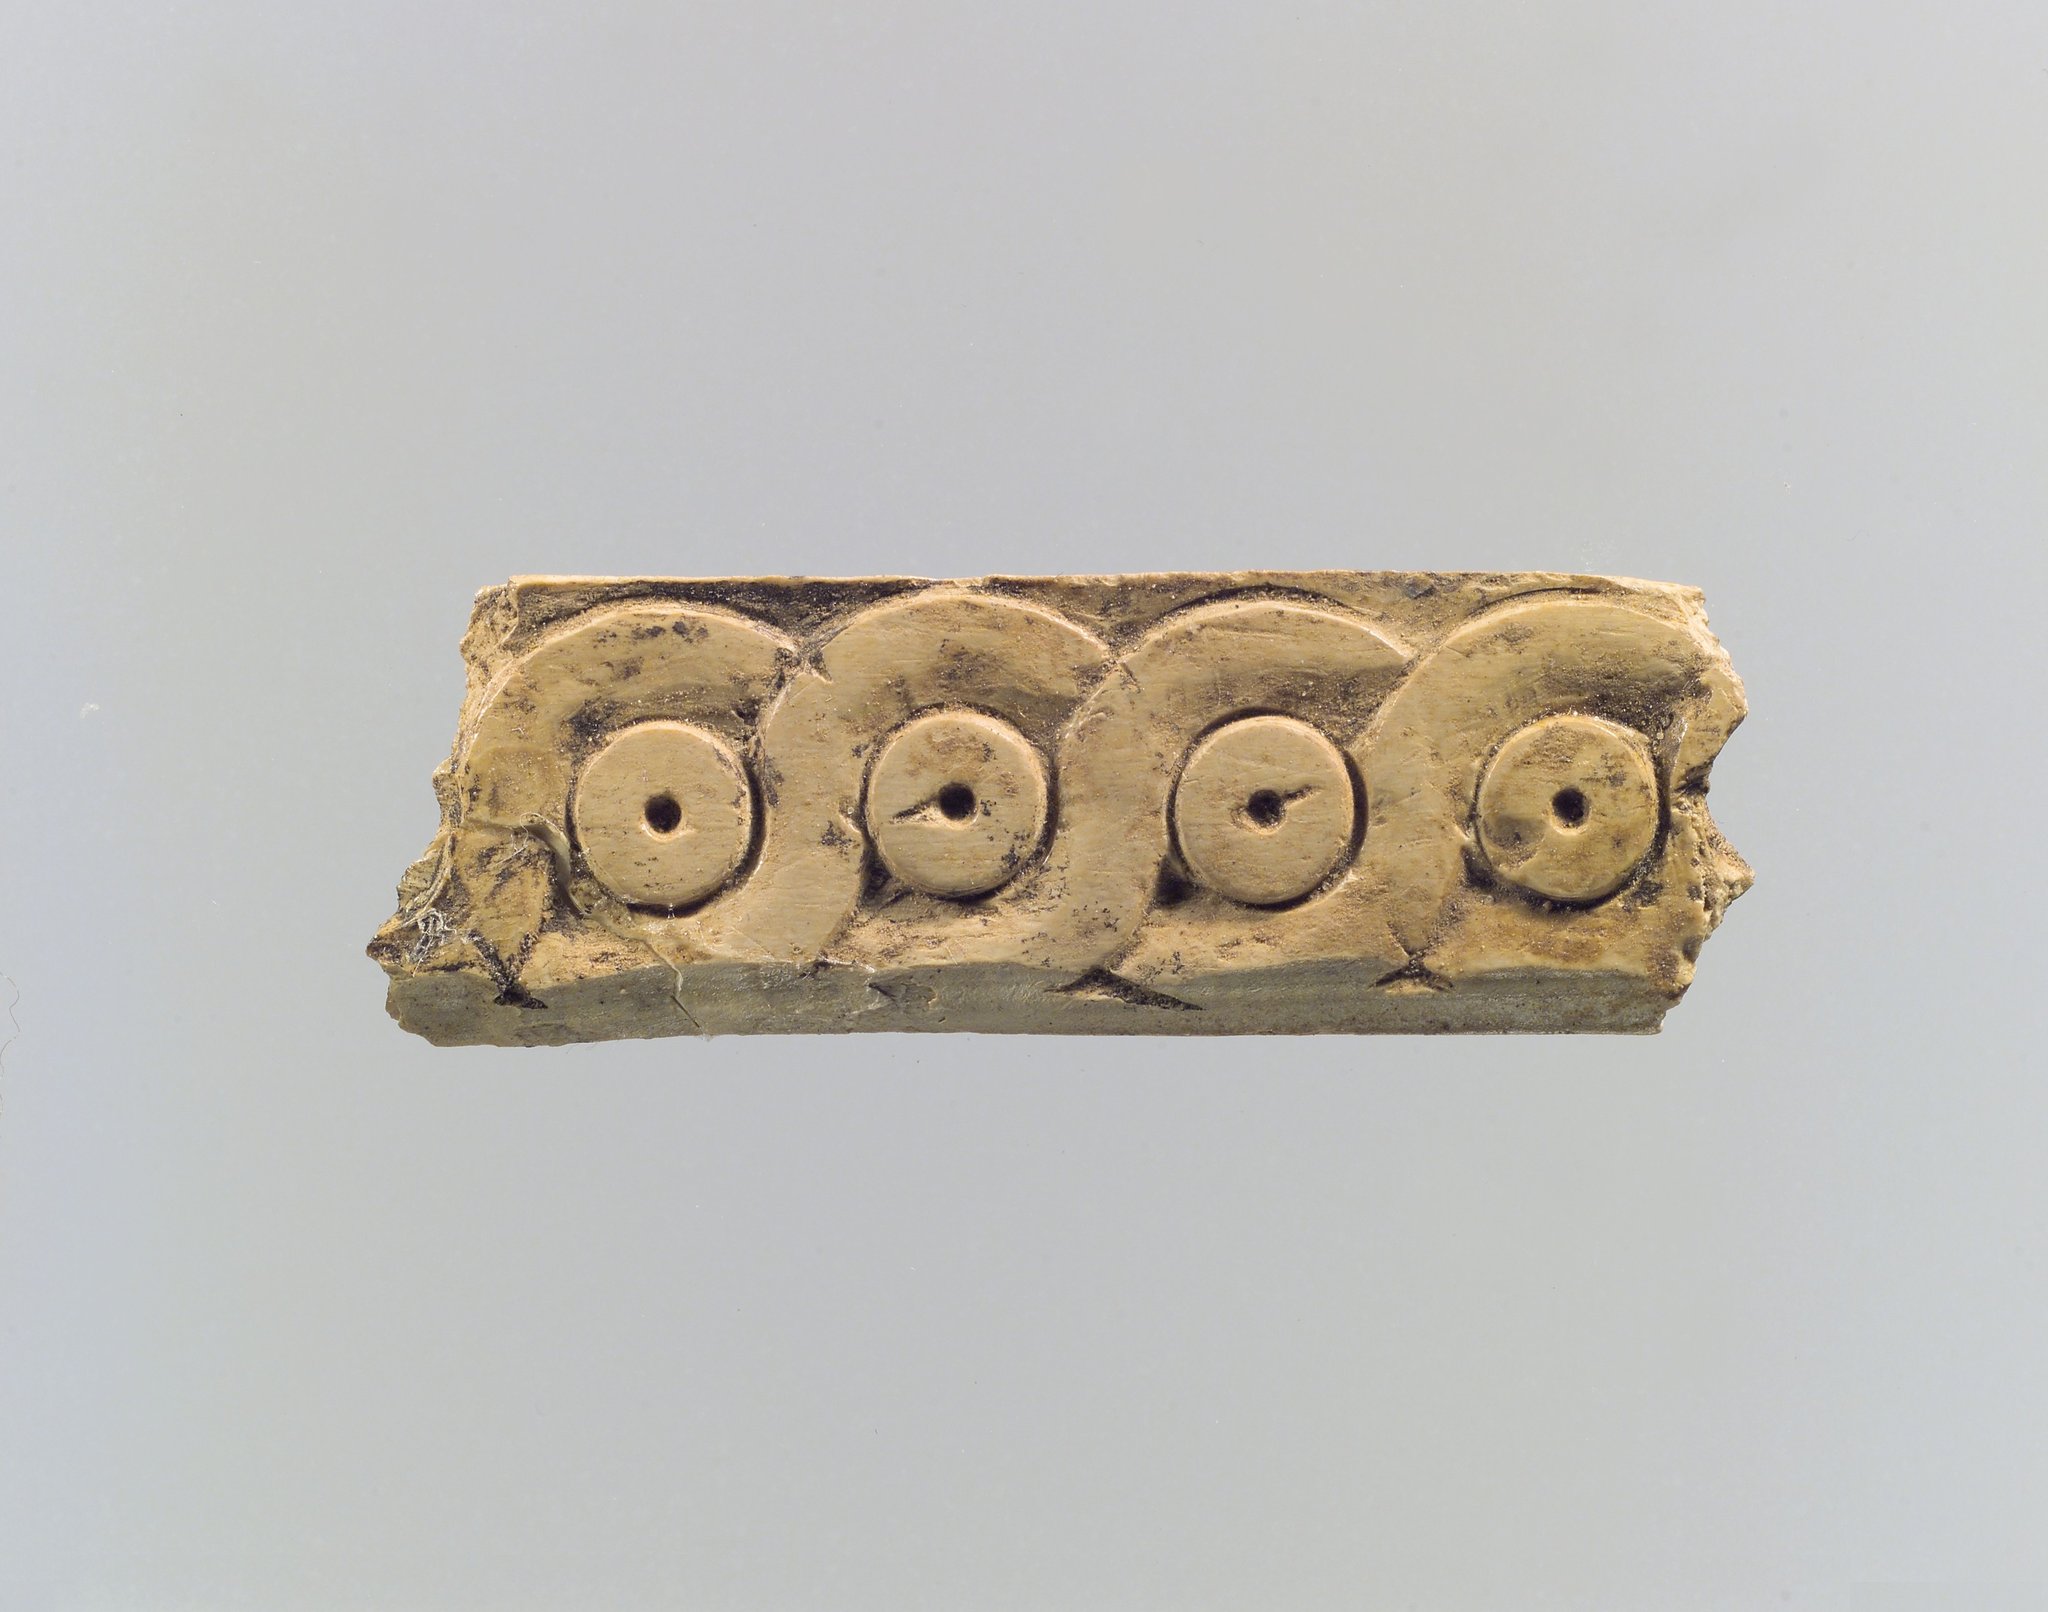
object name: relief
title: Border strip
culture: assyrian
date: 900-701 BCE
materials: ivory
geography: mesopotamia